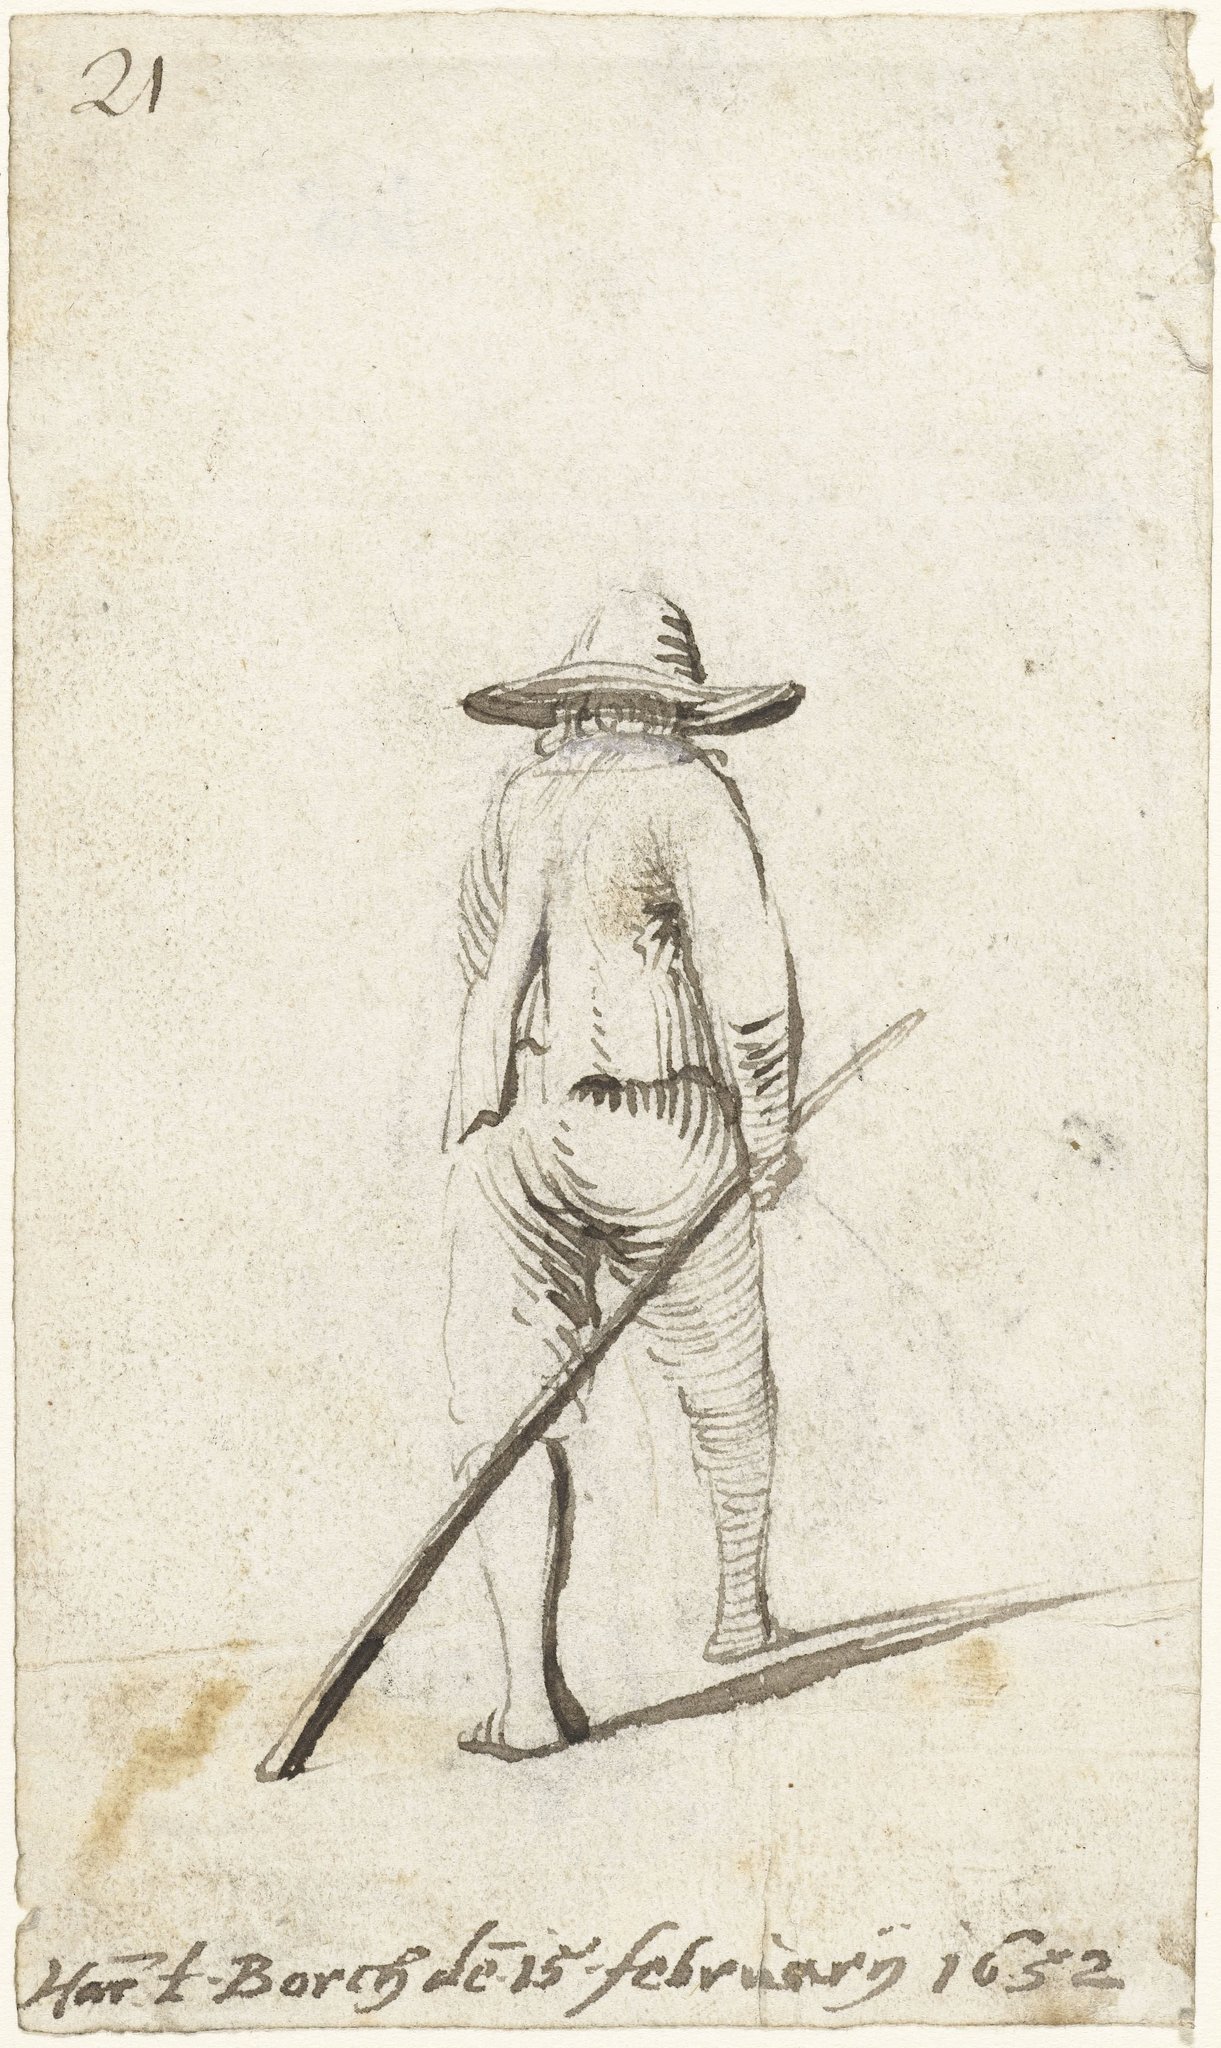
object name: drawing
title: Lopende man met lange stok in zijn hand, van achteren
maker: harmen ter borch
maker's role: draughtsman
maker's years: 1638-1677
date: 1652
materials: chalk, ink, paper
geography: zwolle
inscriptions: annotation: ‘Har[man] t.Borch de[n] 15.februarij 1652’